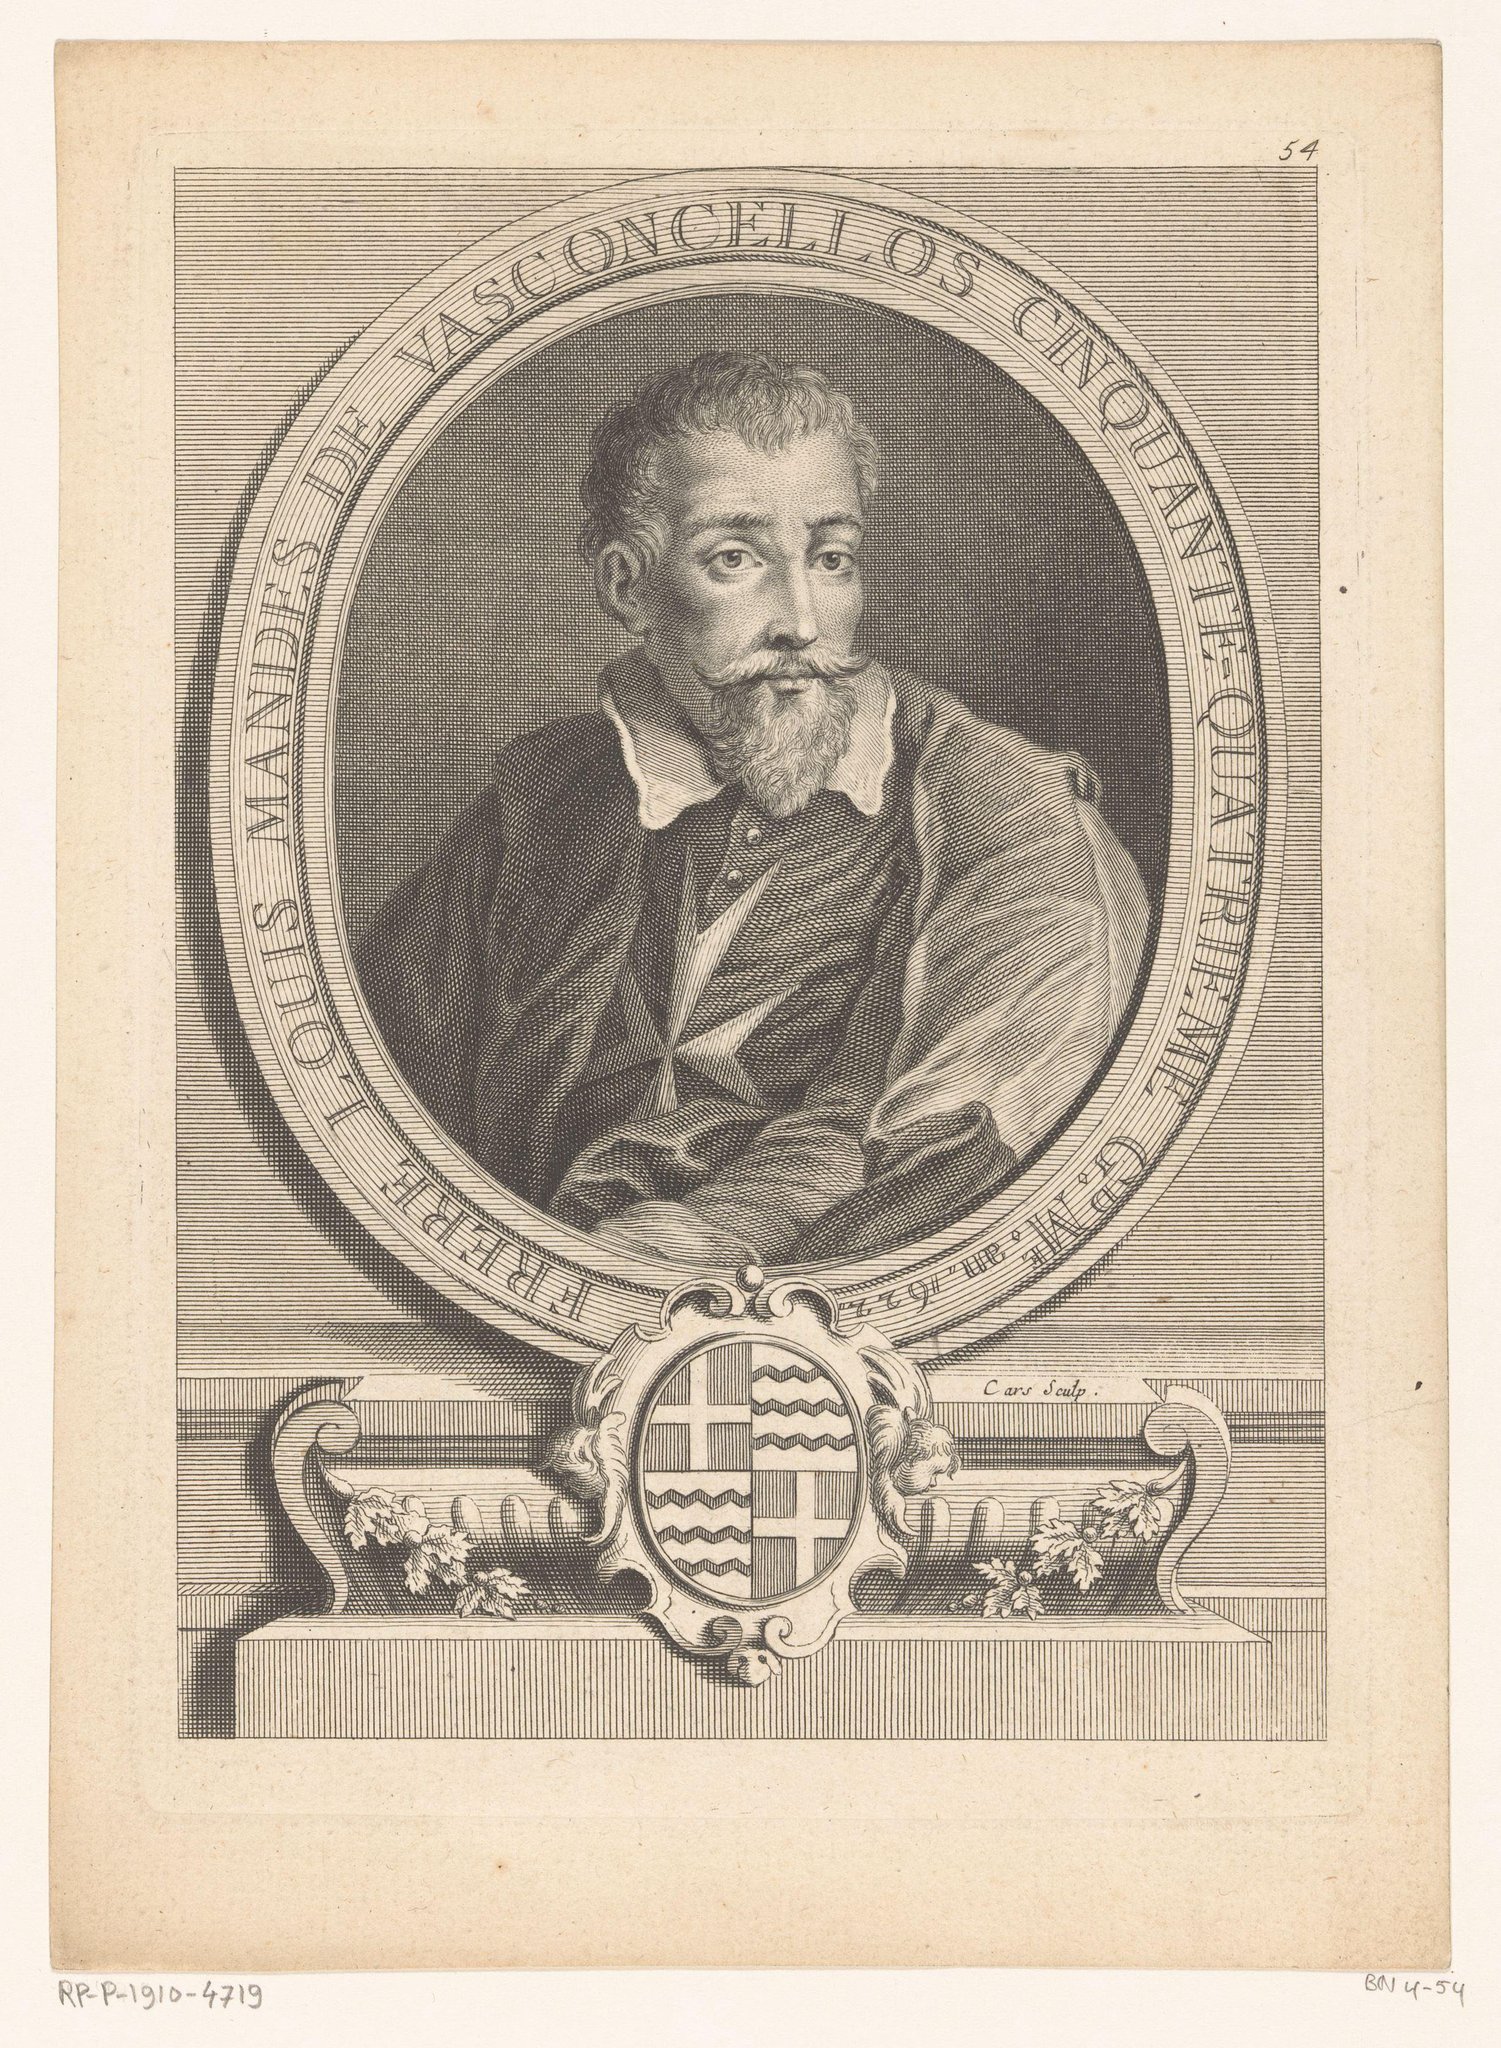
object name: print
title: Portret van Luis Mendez de Vasconcellos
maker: laurent cars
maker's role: print maker, publisher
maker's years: 1699-1771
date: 1726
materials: paper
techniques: engraving, etching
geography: france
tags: historical persons, military orders, e.g.: knights templars, knights of malta, teutonic knights ~ roman catholic church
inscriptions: collector's mark: Lugt 2228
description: Prent uit: Vertot, René Aubert de. Histoire des Chevaliers hospitaliers de St Jean de Jérusalem. Parijs: Rollin, Quillau, Desaint, 1726. Illustratie op p. 132 van deel 3. Cars vervaardigde portretten van 65 grootmeesters van de Maltezer Orde.